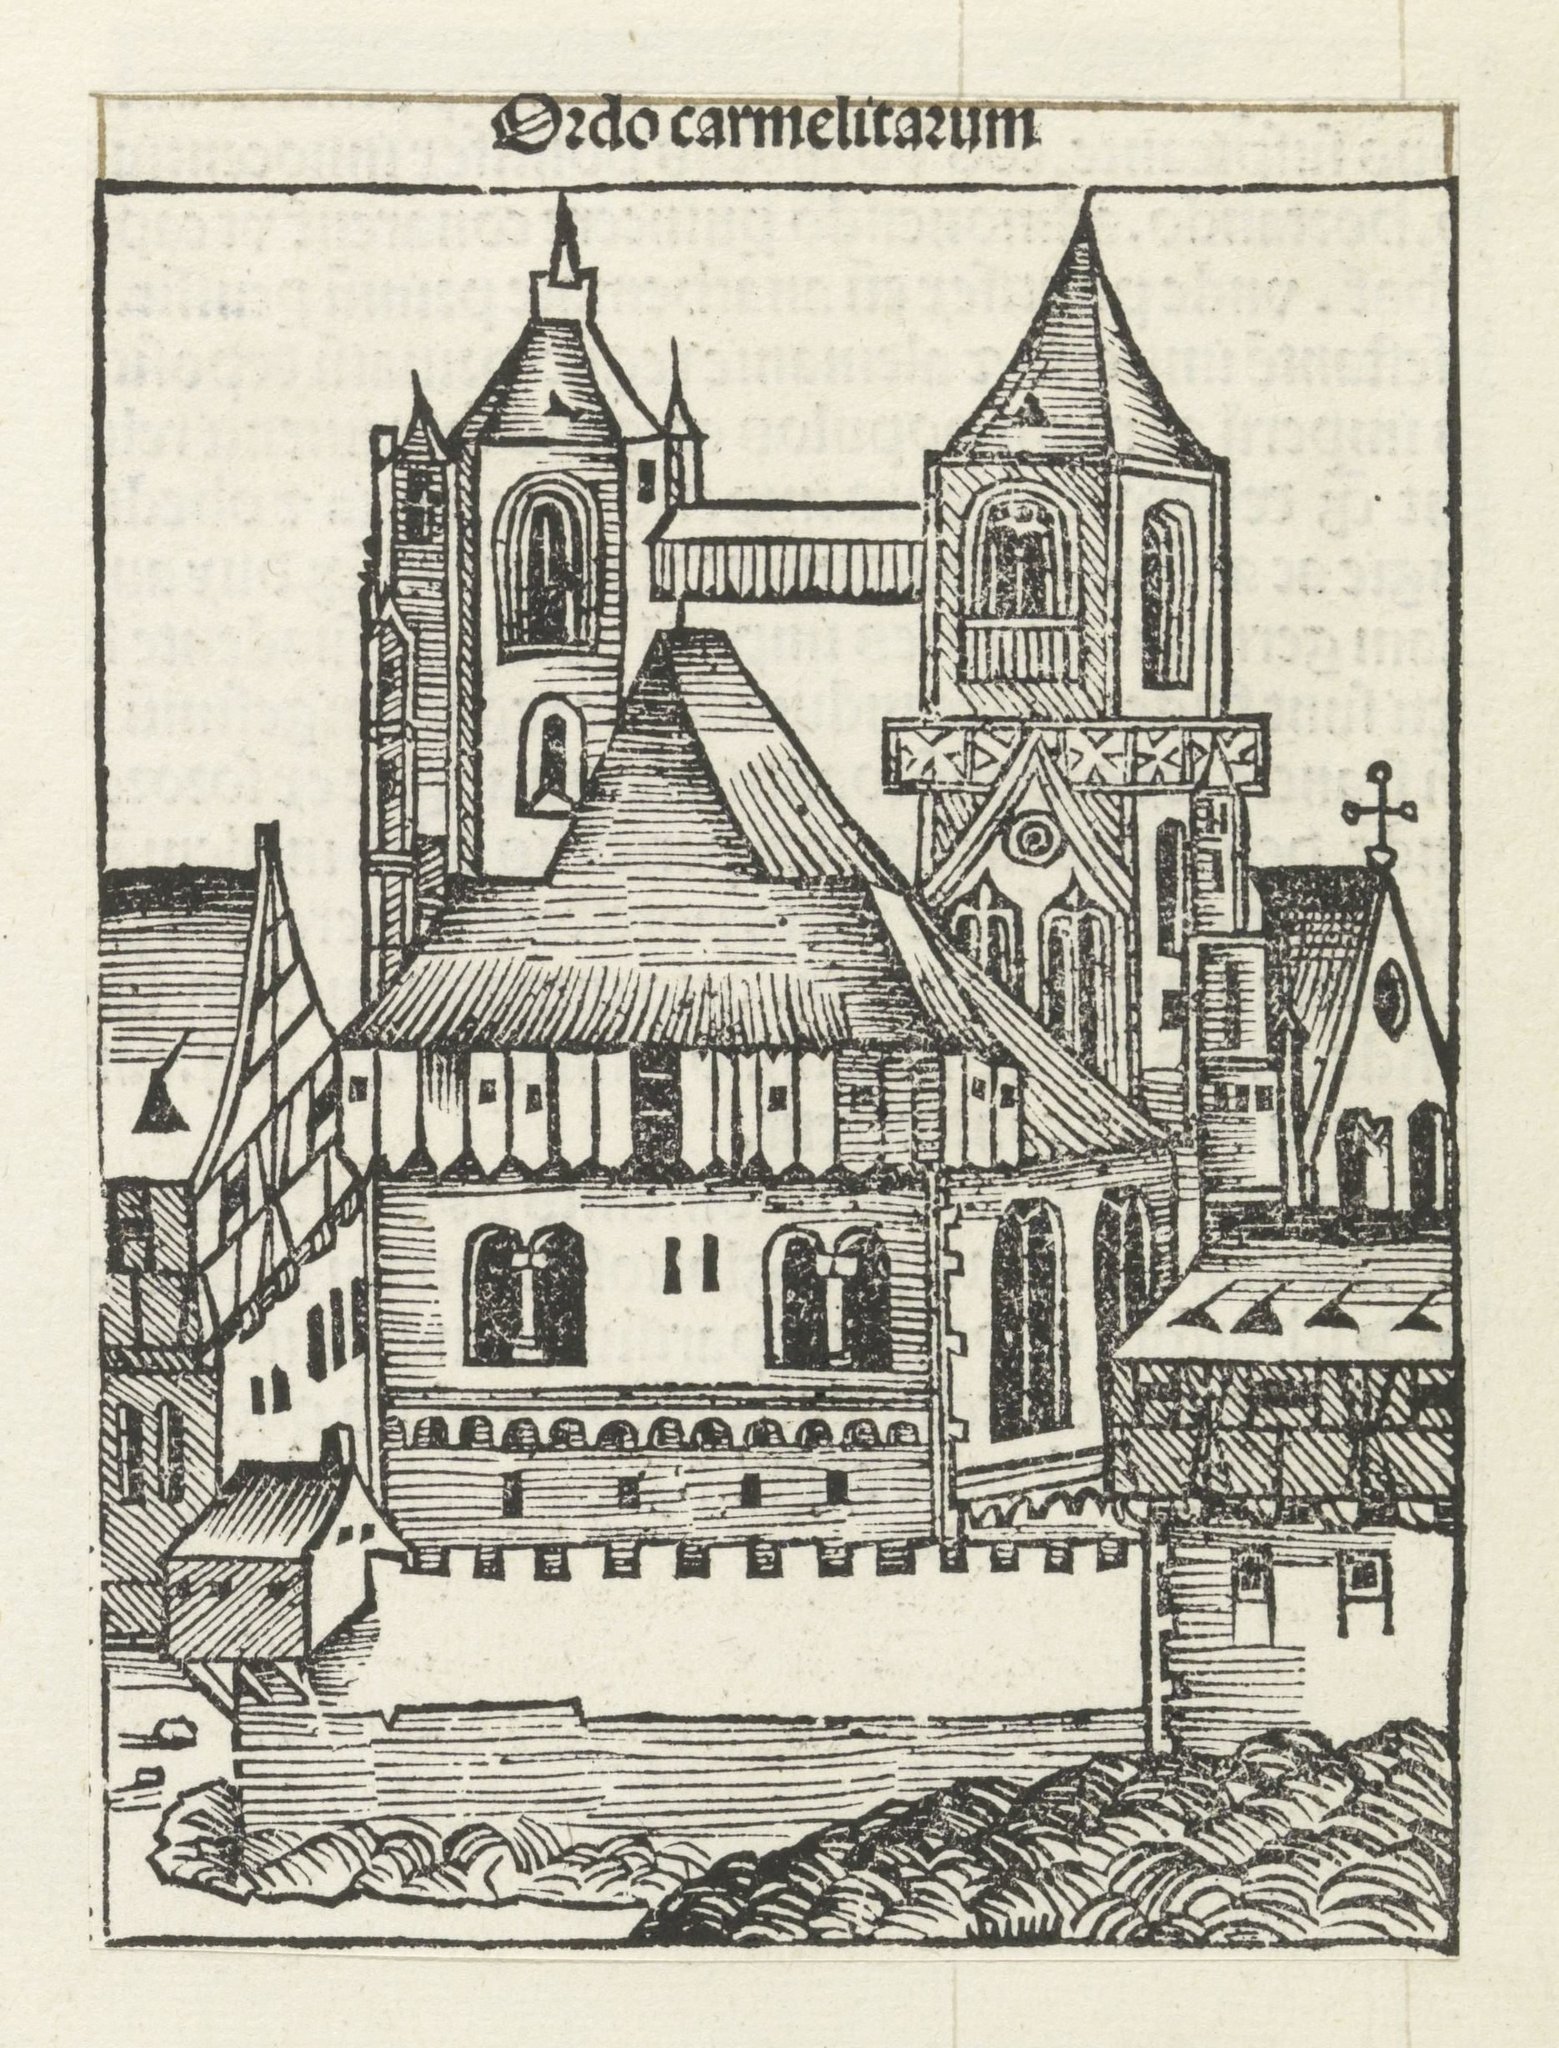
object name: print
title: Orde van de karmelieten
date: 1493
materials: paper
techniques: letterpress printing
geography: nuremberg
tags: abbey, monastery, convent ~ roman catholic church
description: De houtsnede wordt herhaaldelijk gebruikt als boekillustratie in de Liber Chronicarum (of Neurenbergkroniek) van Hartmann Schedel, verschenen in het Latijn en Duits in 1493. Zie de Latijnse uitgave, folio 207v.